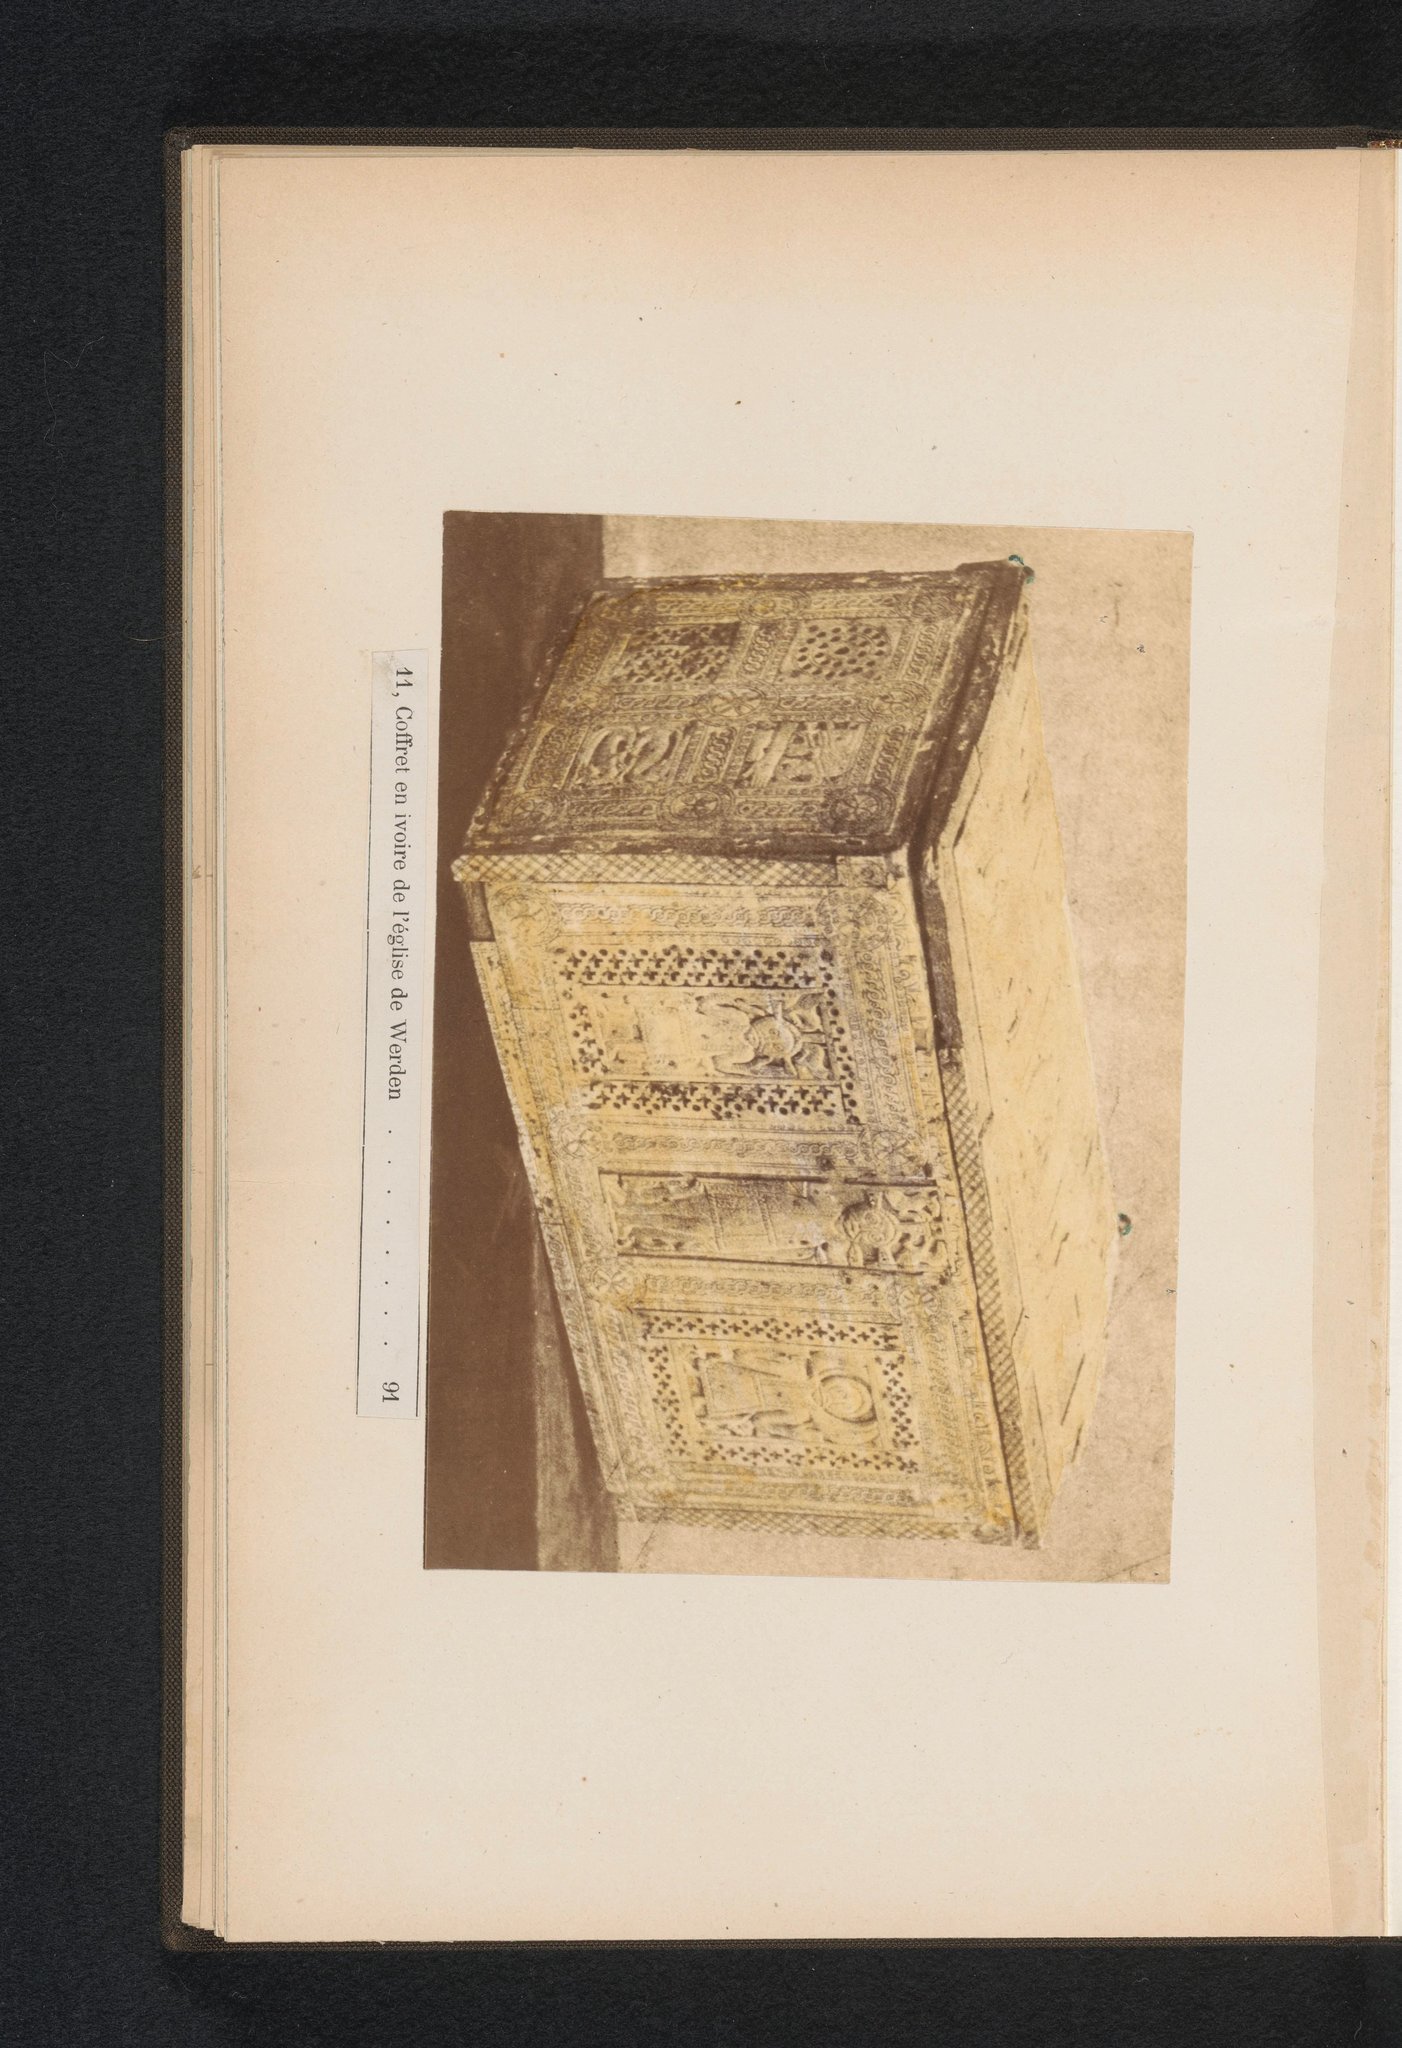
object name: page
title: Coffret en ivoire de l'église de Werden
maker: Anonymous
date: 1877-1882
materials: photographic support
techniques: albumen print, hand coloring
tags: chest, coffer